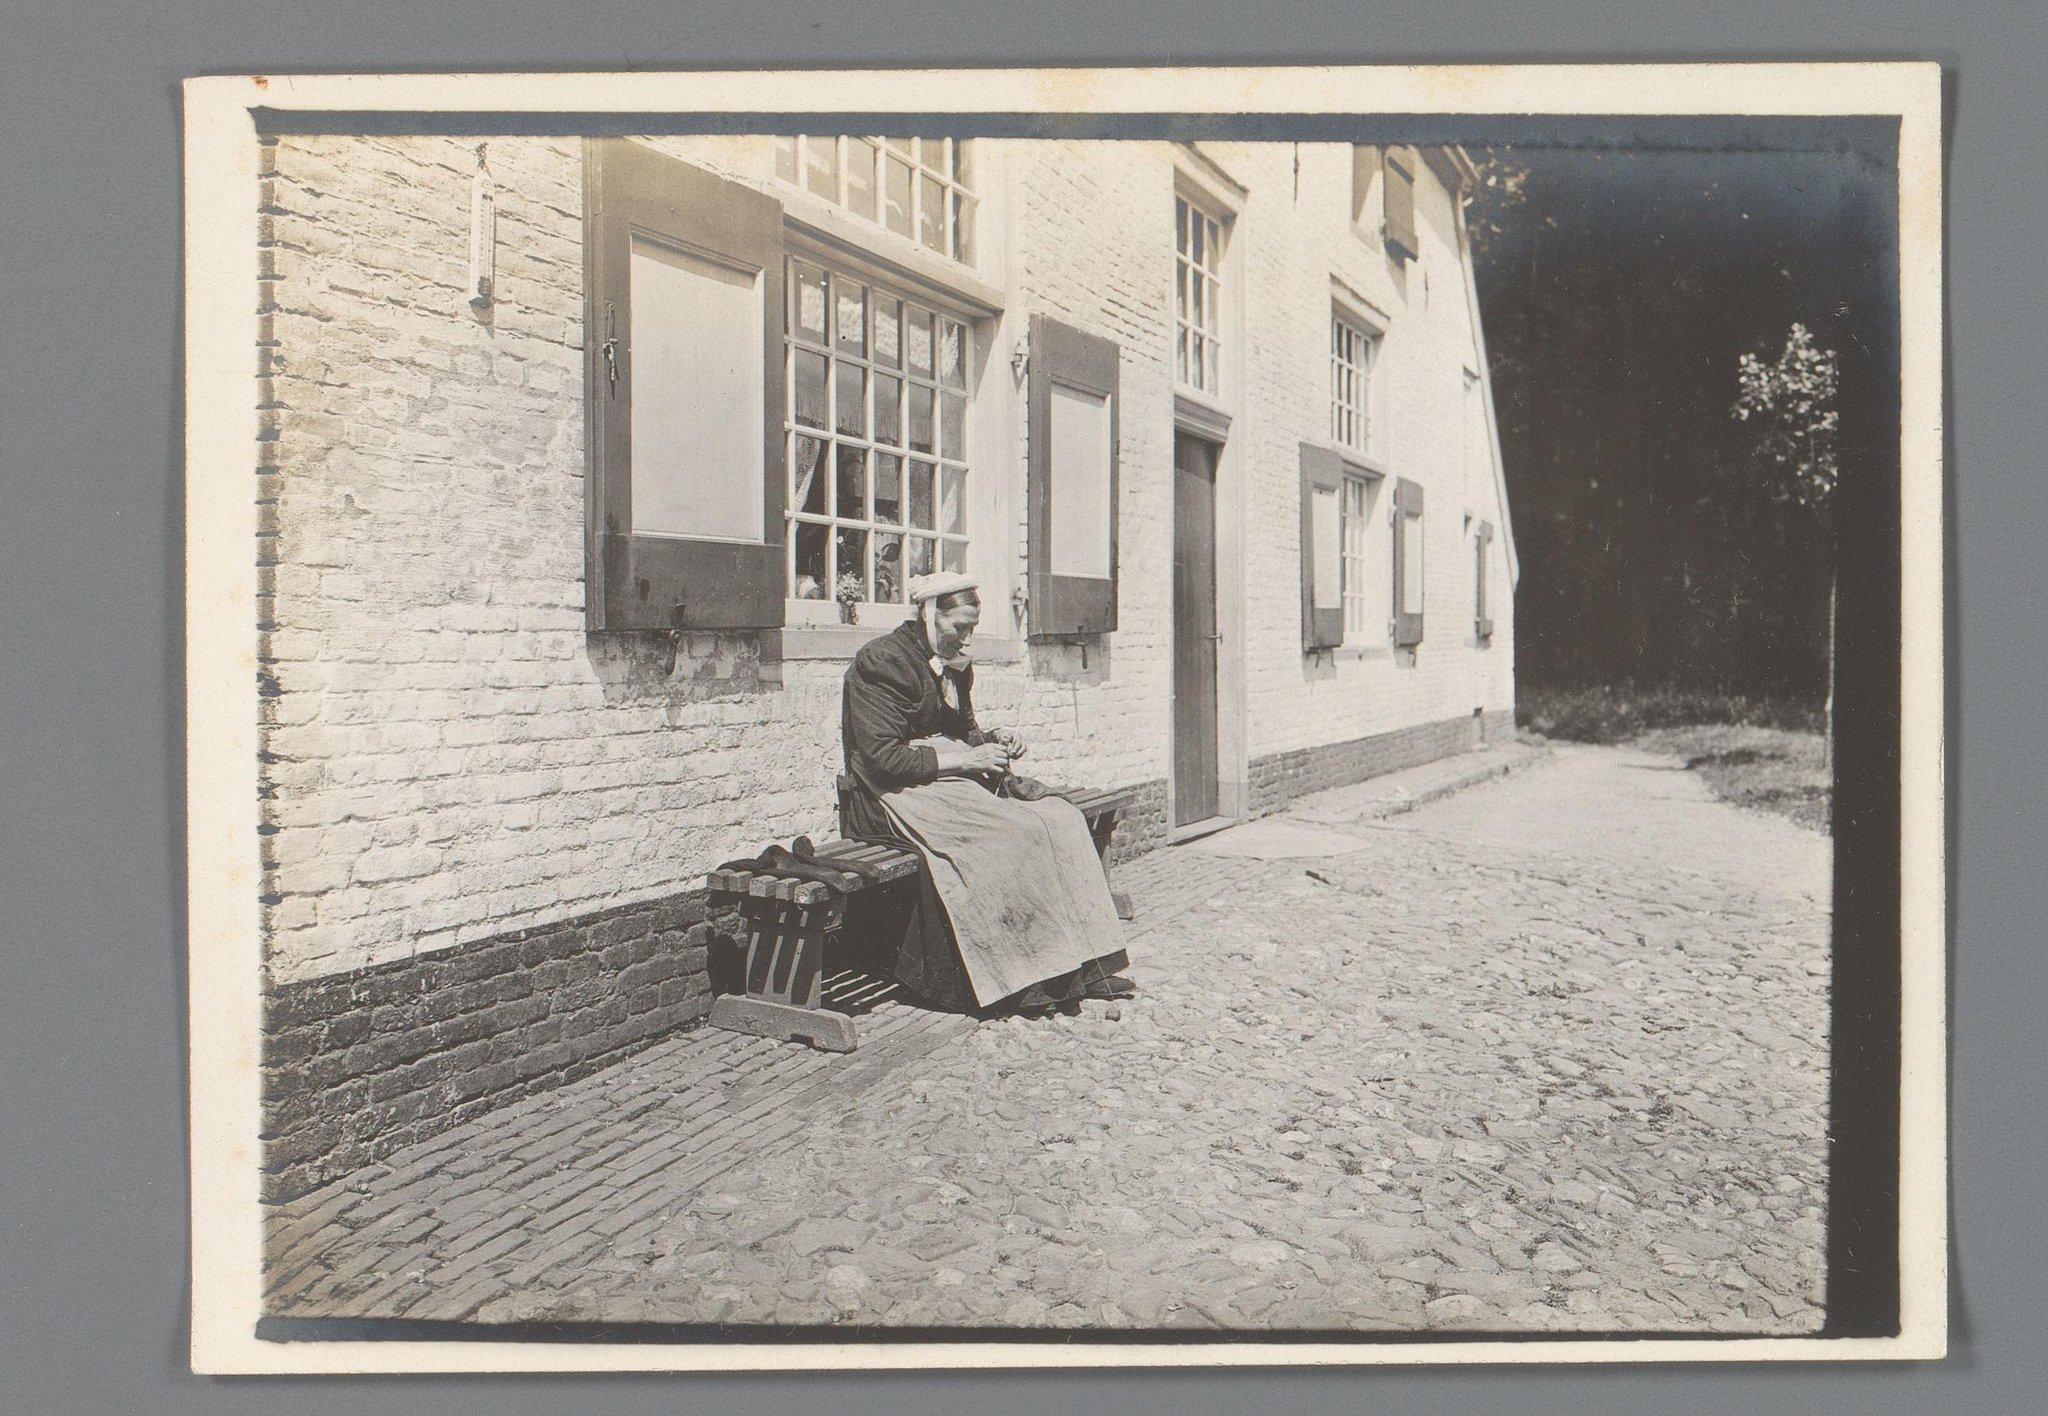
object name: photograph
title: Breiende vrouw voor een boerderij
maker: willem de jong (fotograaf)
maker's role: arts, fotograaf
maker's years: 1864-1918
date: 1895-1918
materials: paper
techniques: gelatin silver print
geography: netherlands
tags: knitting, farm (building)